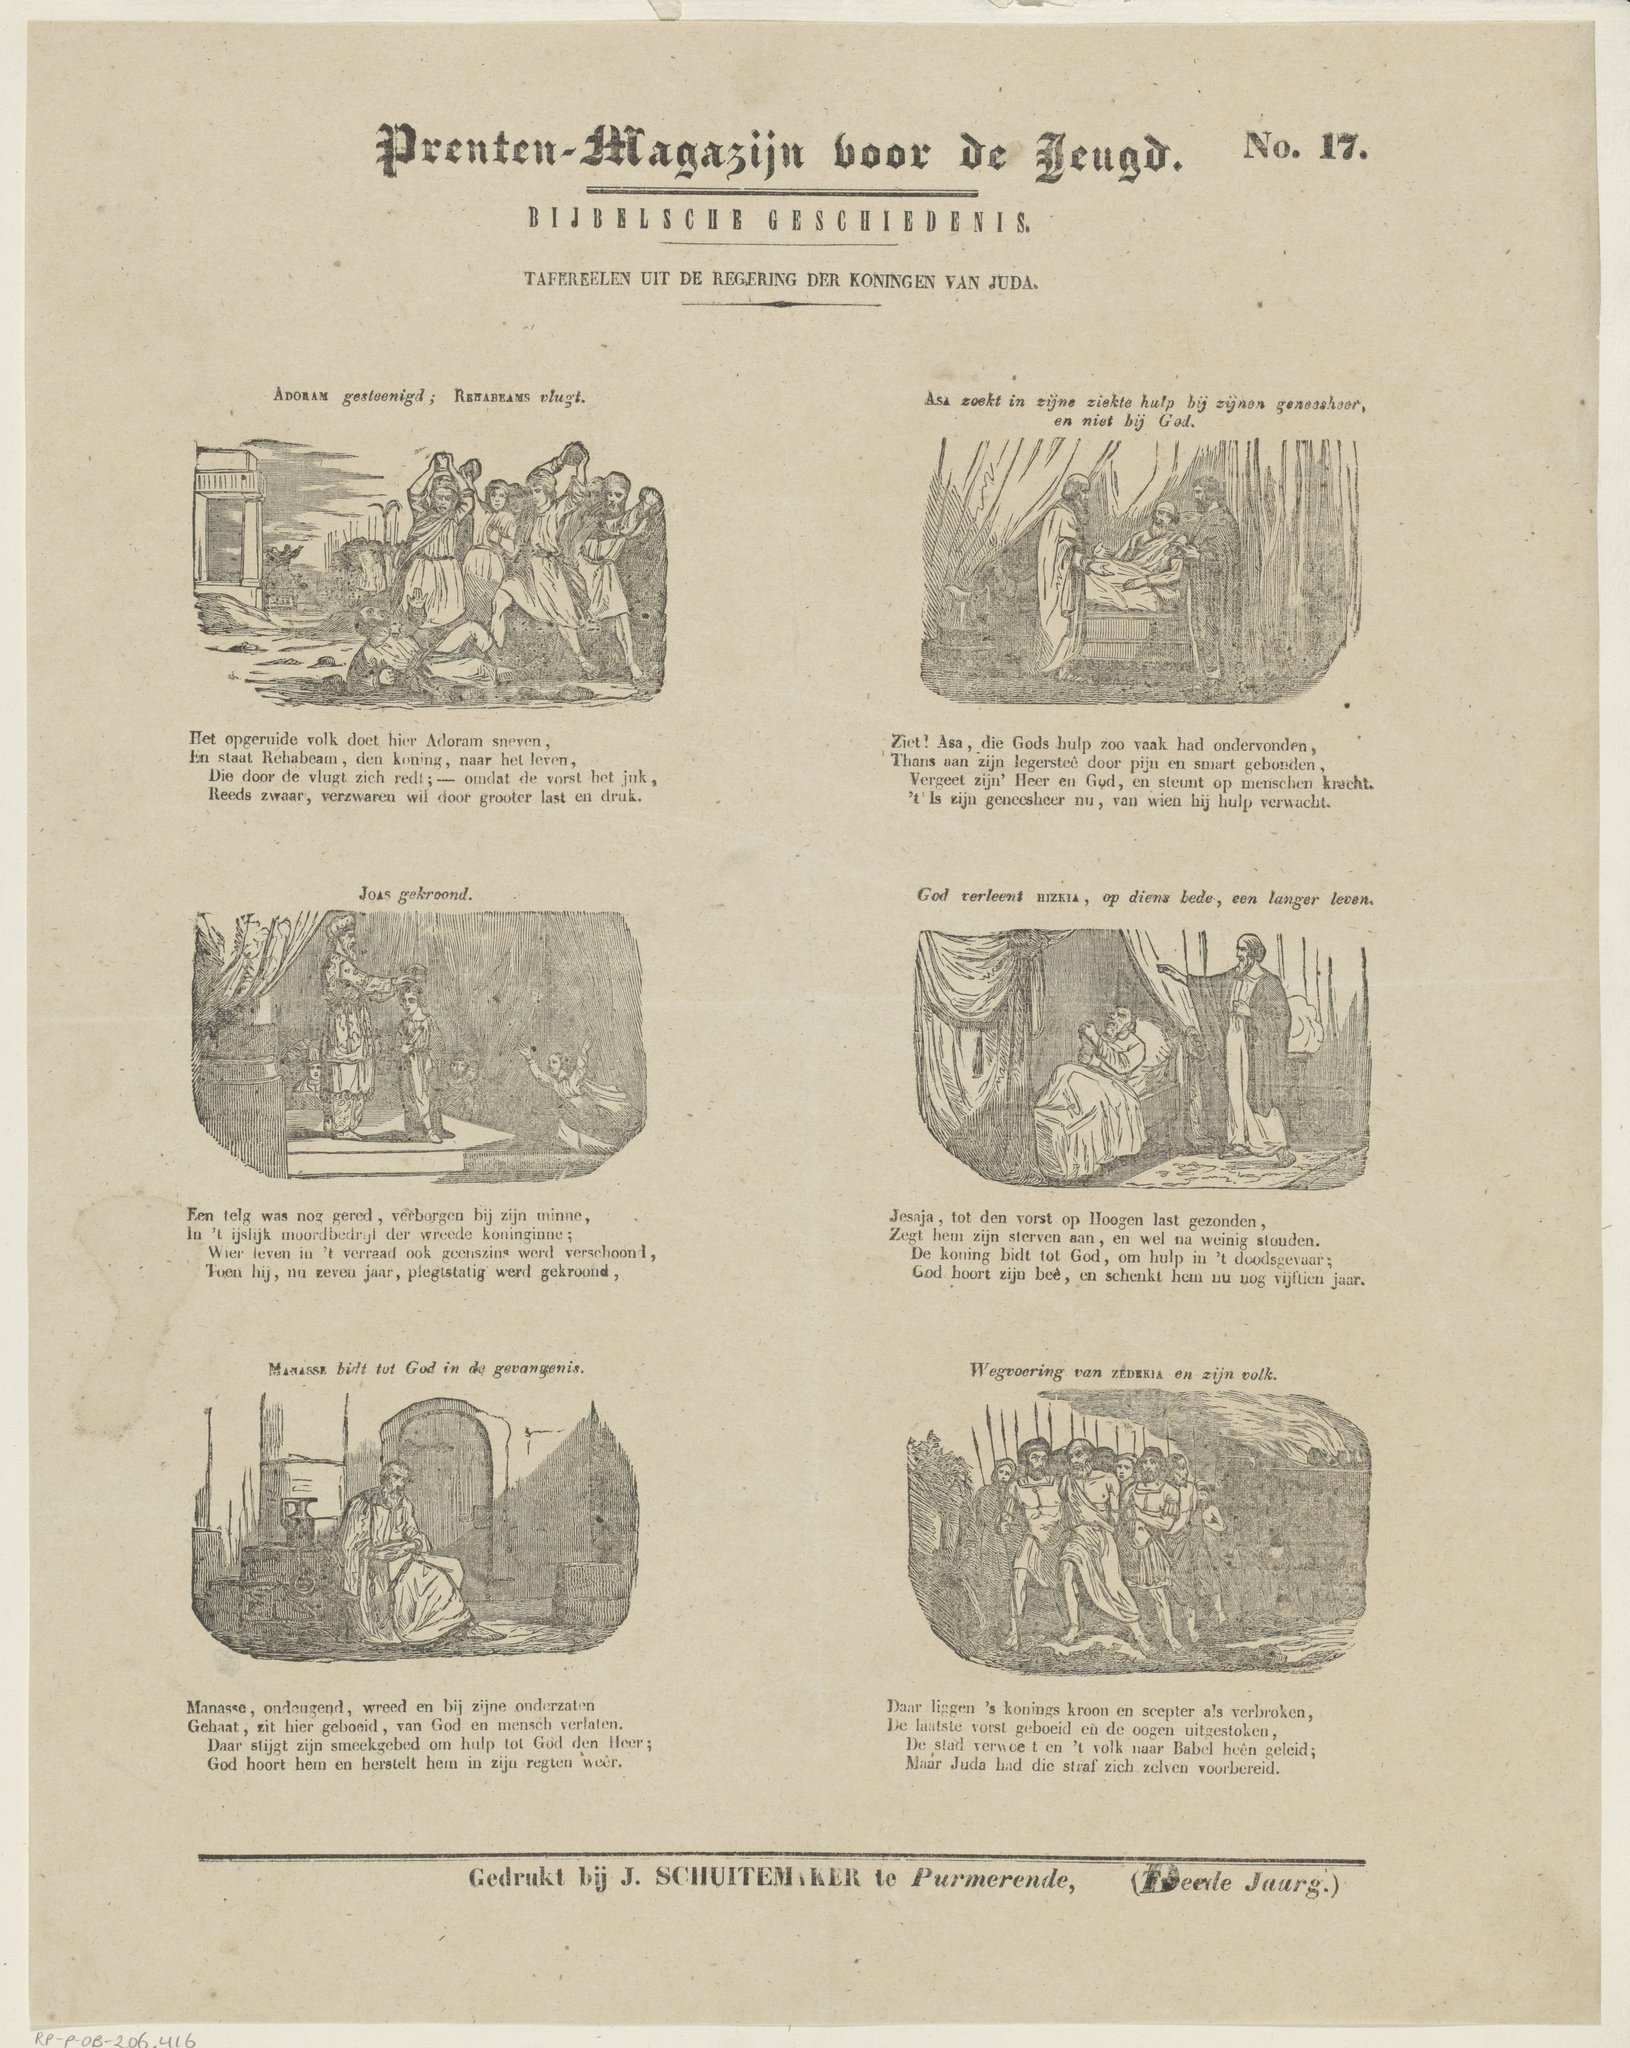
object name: print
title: Prenten-magazijn voor de jeugd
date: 1844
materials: paper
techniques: letterpress printing, engraving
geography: purmerend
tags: zedekiah is captured by the babylonians, adoram is stoned to death; rehoboam escapes in his chariot to jerusalem, story of manasseh, son of hezekiah, king of judah (2 kings 21:1-18; 2 chronicles 33:1-20), hezekiah's illness and recovery (2 kings 20:1-11; isaiah 38), asa turns to the doctors instead of god for help, joash is proclaimed king at the age of seven, old testament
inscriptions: collector's mark: Lugt 2760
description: Blad met 6 voorstellingen over de regeringsperioden van de oudtestamentische koningen van Juda. Boven elke voorstelling een titel en onder elke voorstelling een vierregelig vers. Genummerd rechtsboven: No. 17.